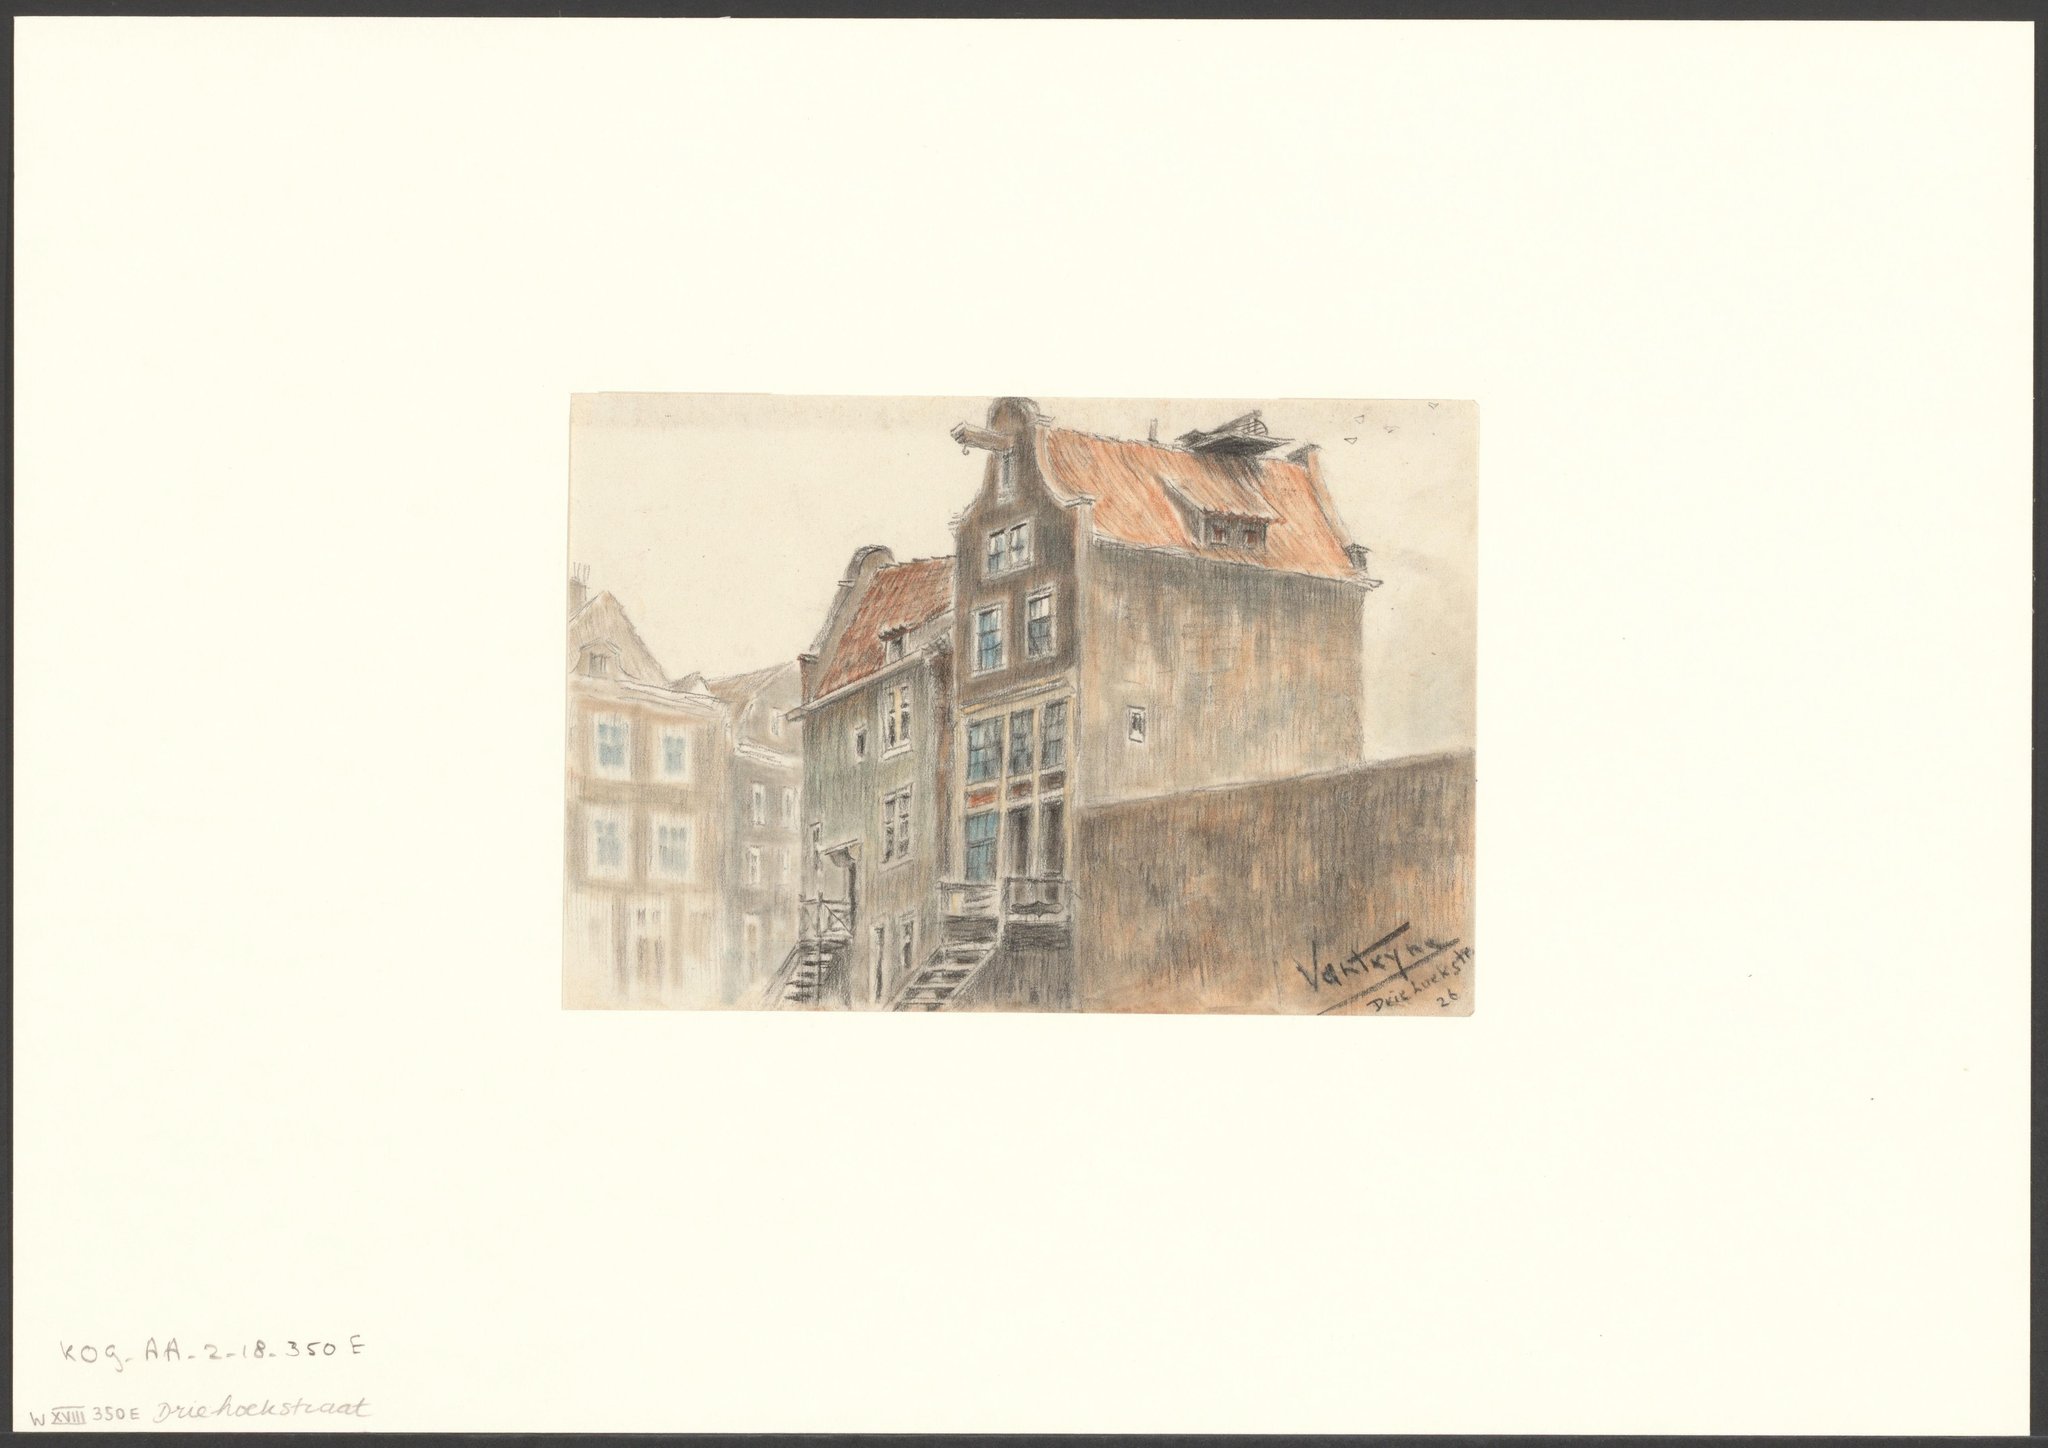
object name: drawing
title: Gezicht op panden aan de Driehoekstraat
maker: anthonie van teijn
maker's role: draughtsman, painter, print maker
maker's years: 1863-1943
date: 1926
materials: chalk, paper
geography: amsterdam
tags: city-view in general; 'veduta', façade (of house or building), street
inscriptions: stamp: ‘J. van Eck.’, signature and date: ‘VanTeyne / 26’, inscription: ‘Driehoekstr’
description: Tekening binnen de Atlas Van Eck ingedeeld op wijknummer 18.